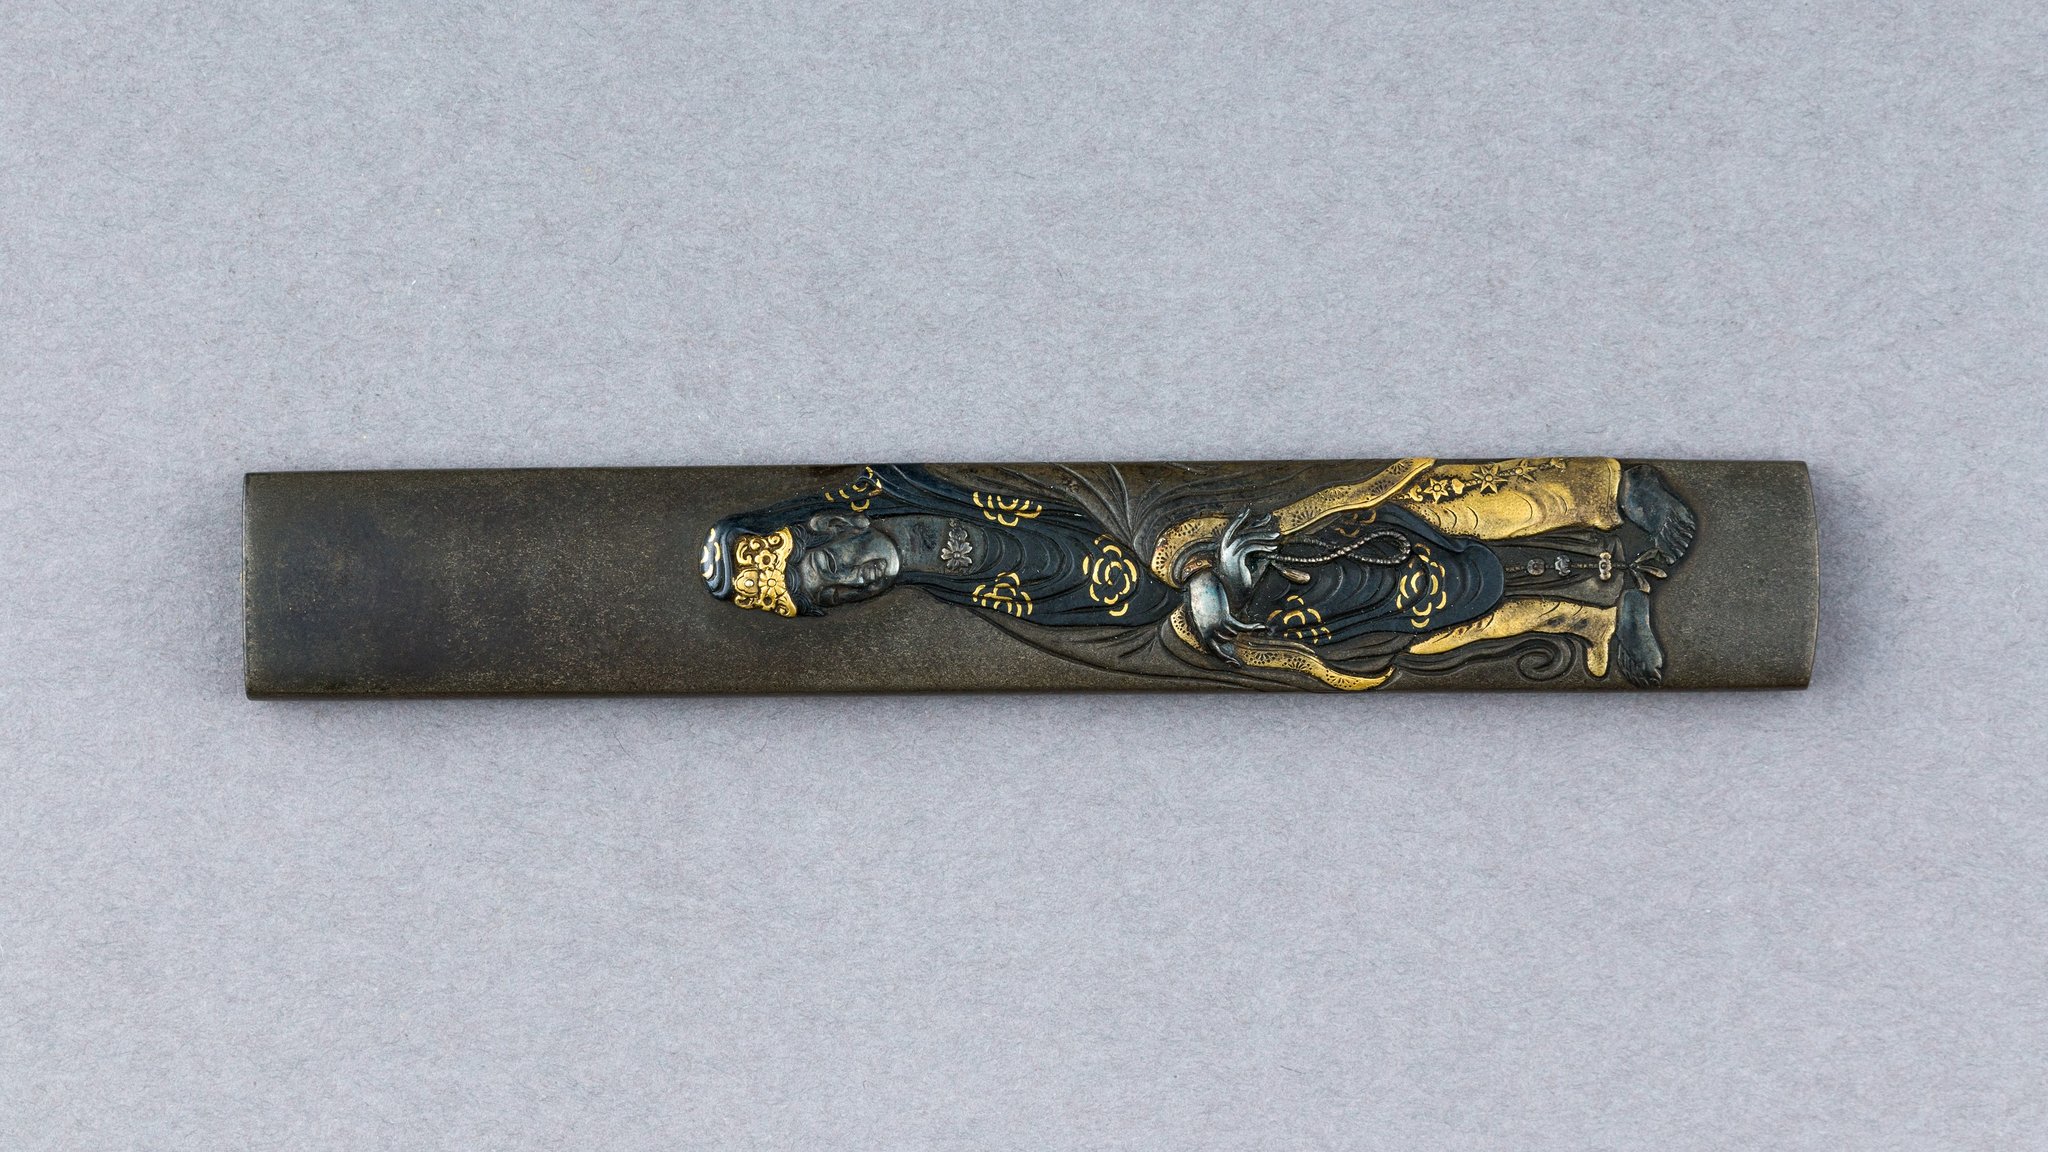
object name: knife handle kozuka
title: Knife Handle (Kozuka)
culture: japanese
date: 1615-1868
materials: gold alloy, silver alloy, gold, silver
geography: japan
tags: human figures